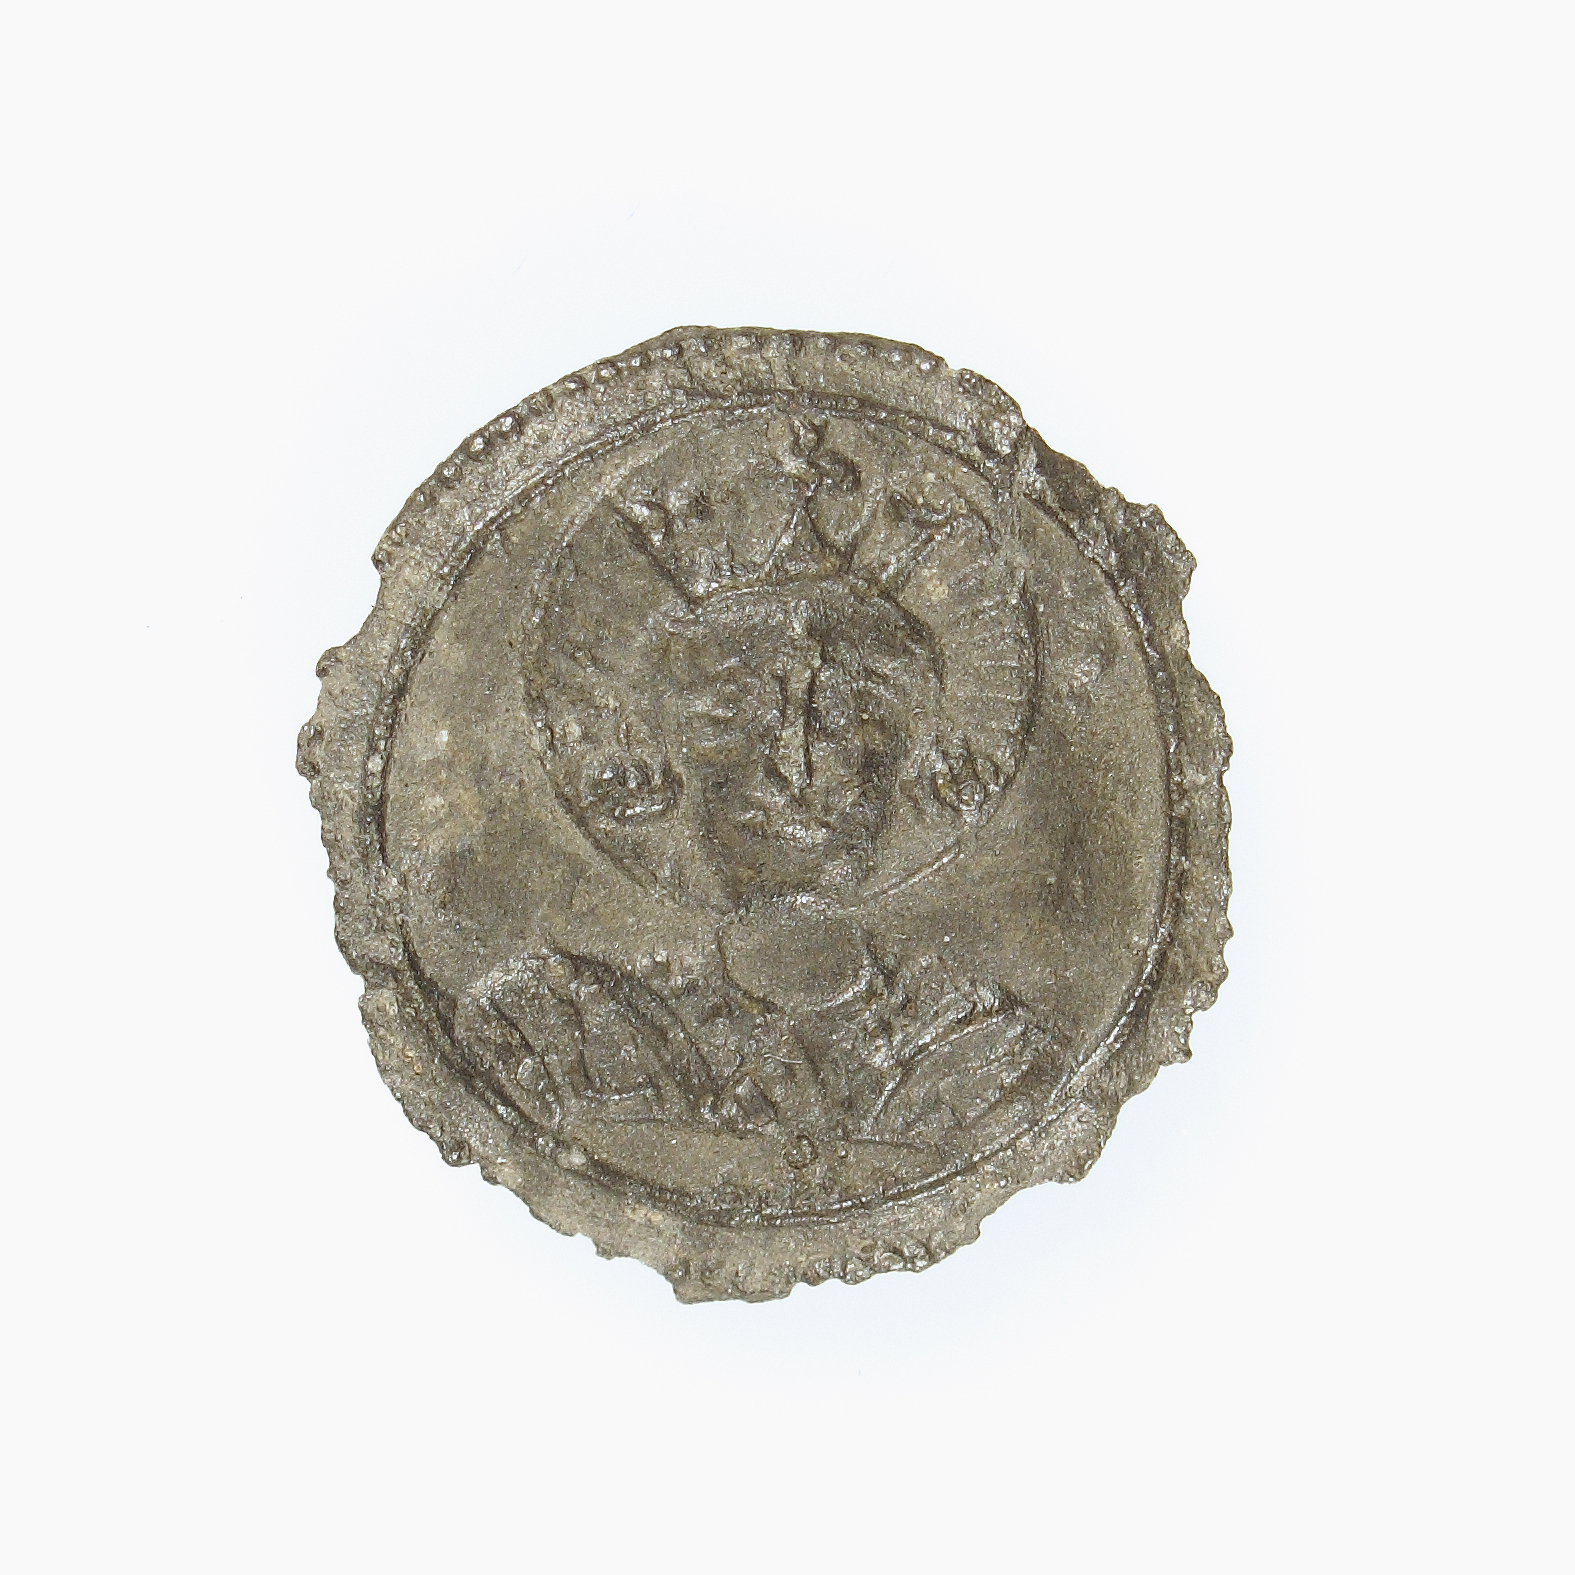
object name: pilgrim's badge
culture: french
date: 1301-1600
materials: lead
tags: saints